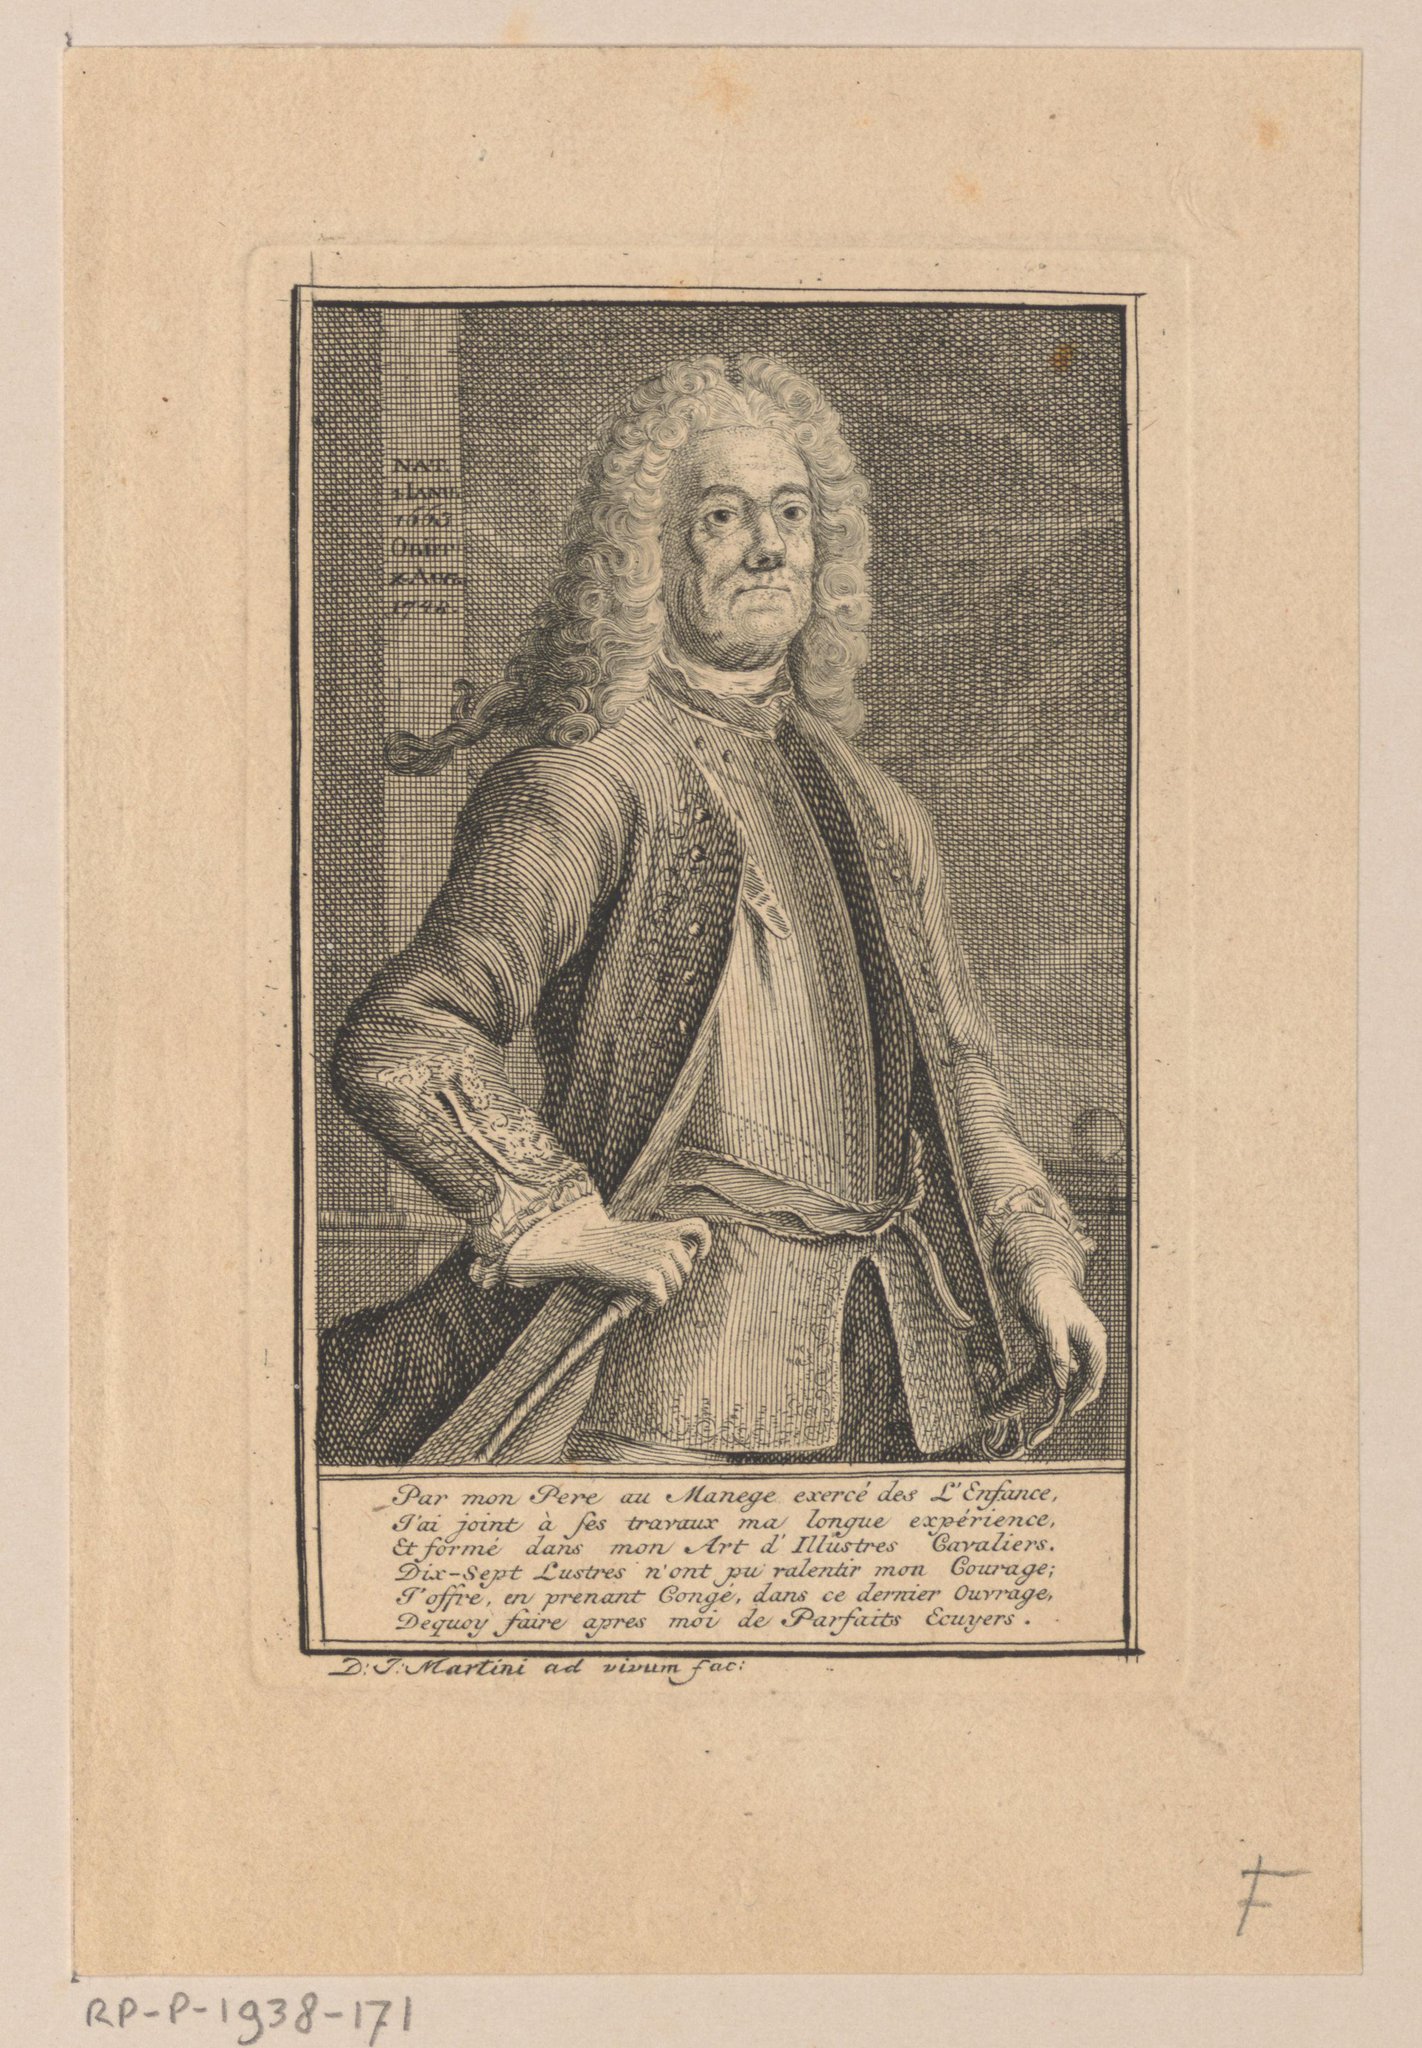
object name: print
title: Portret van Gaspard Saunier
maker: david johannes martini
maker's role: print maker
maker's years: 1720-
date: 1749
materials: paper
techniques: engraving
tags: historical persons, occupations ~ cattle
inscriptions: collector's mark: Lugt 2228, collector's mark: Lugt 2760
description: Prent waarschijnlijk uit: Saunier, Gaspard. Les vrais principes de la cavalerie. Amsterdam: Zacharias Chatelain II, 1749.